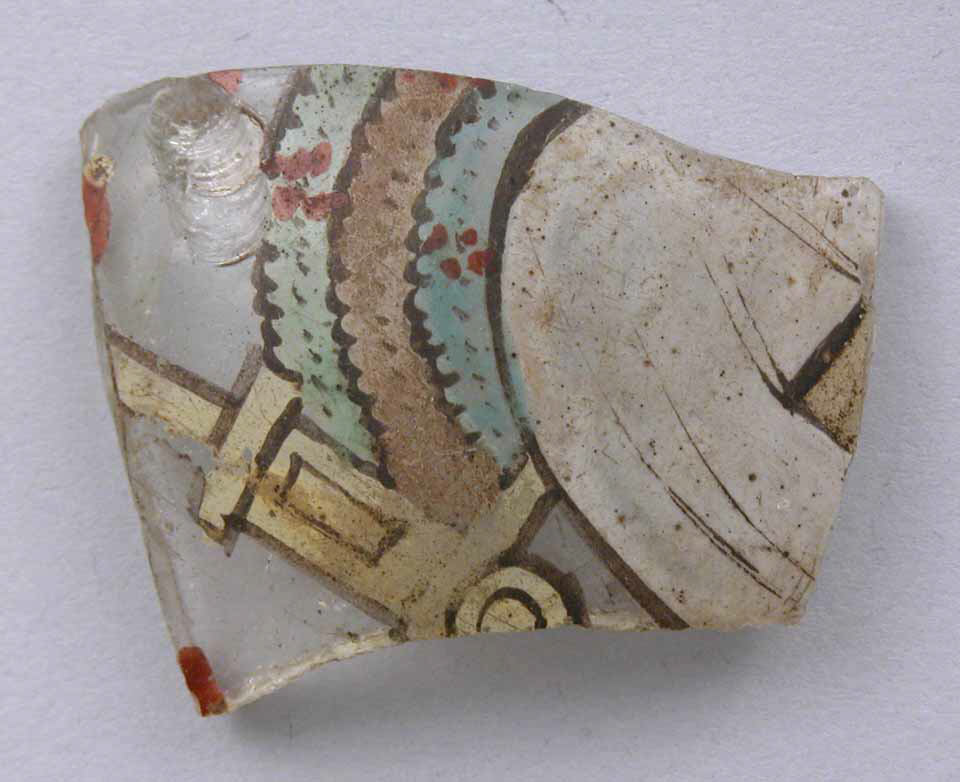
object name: fragment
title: Glass Fragment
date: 1501-1600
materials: glass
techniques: enamel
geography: egypt or syria